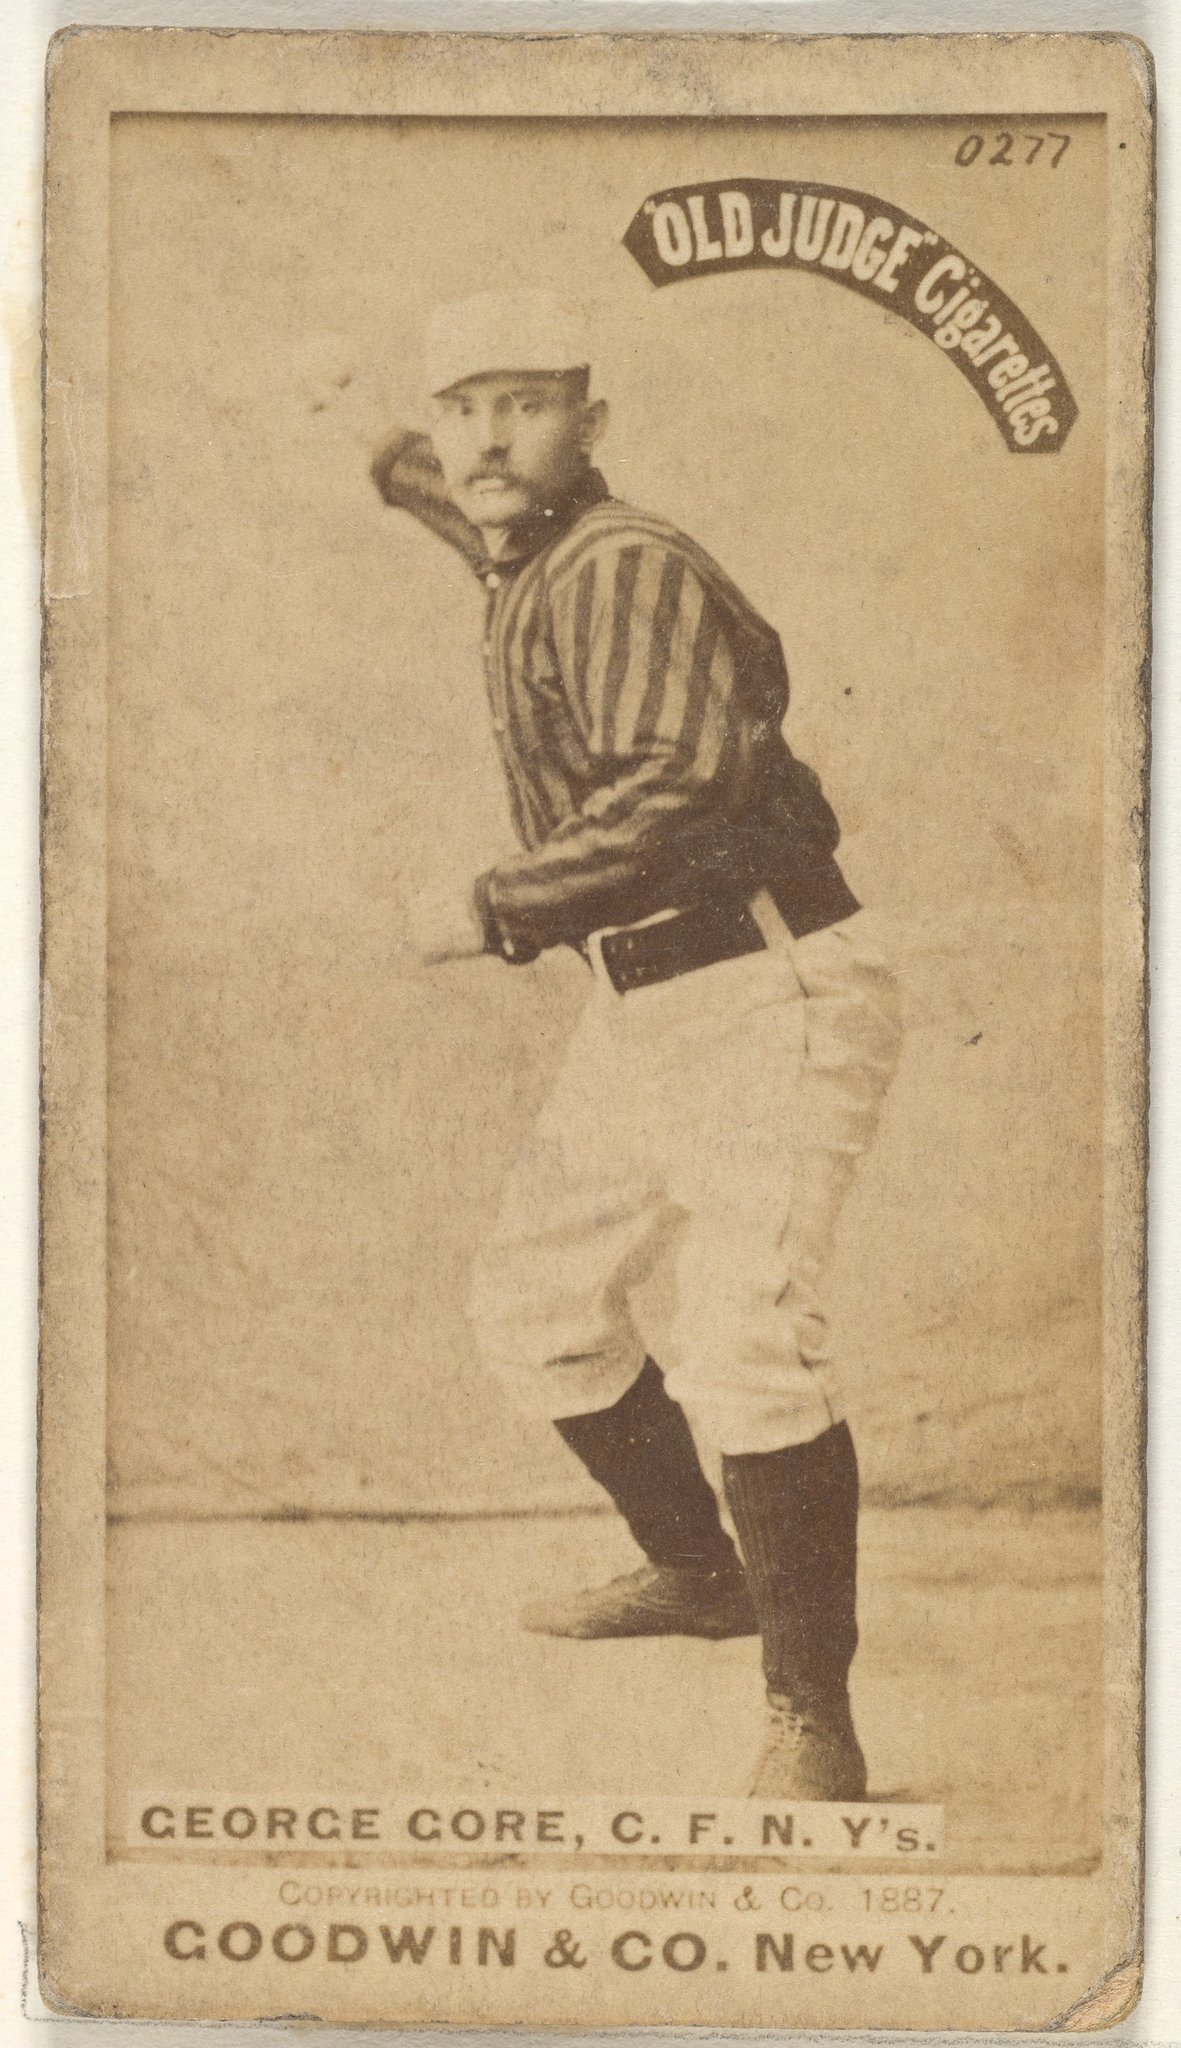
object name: baseball card, photograph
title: George F. "Piano Legs" Gore, Center Field, New York, from the Old Judge series (N172) for Old Judge Cigarettes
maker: goodwin & company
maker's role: publisher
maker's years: 1850-1950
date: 1887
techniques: albumen silver print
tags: men,portraits,baseball,athletes